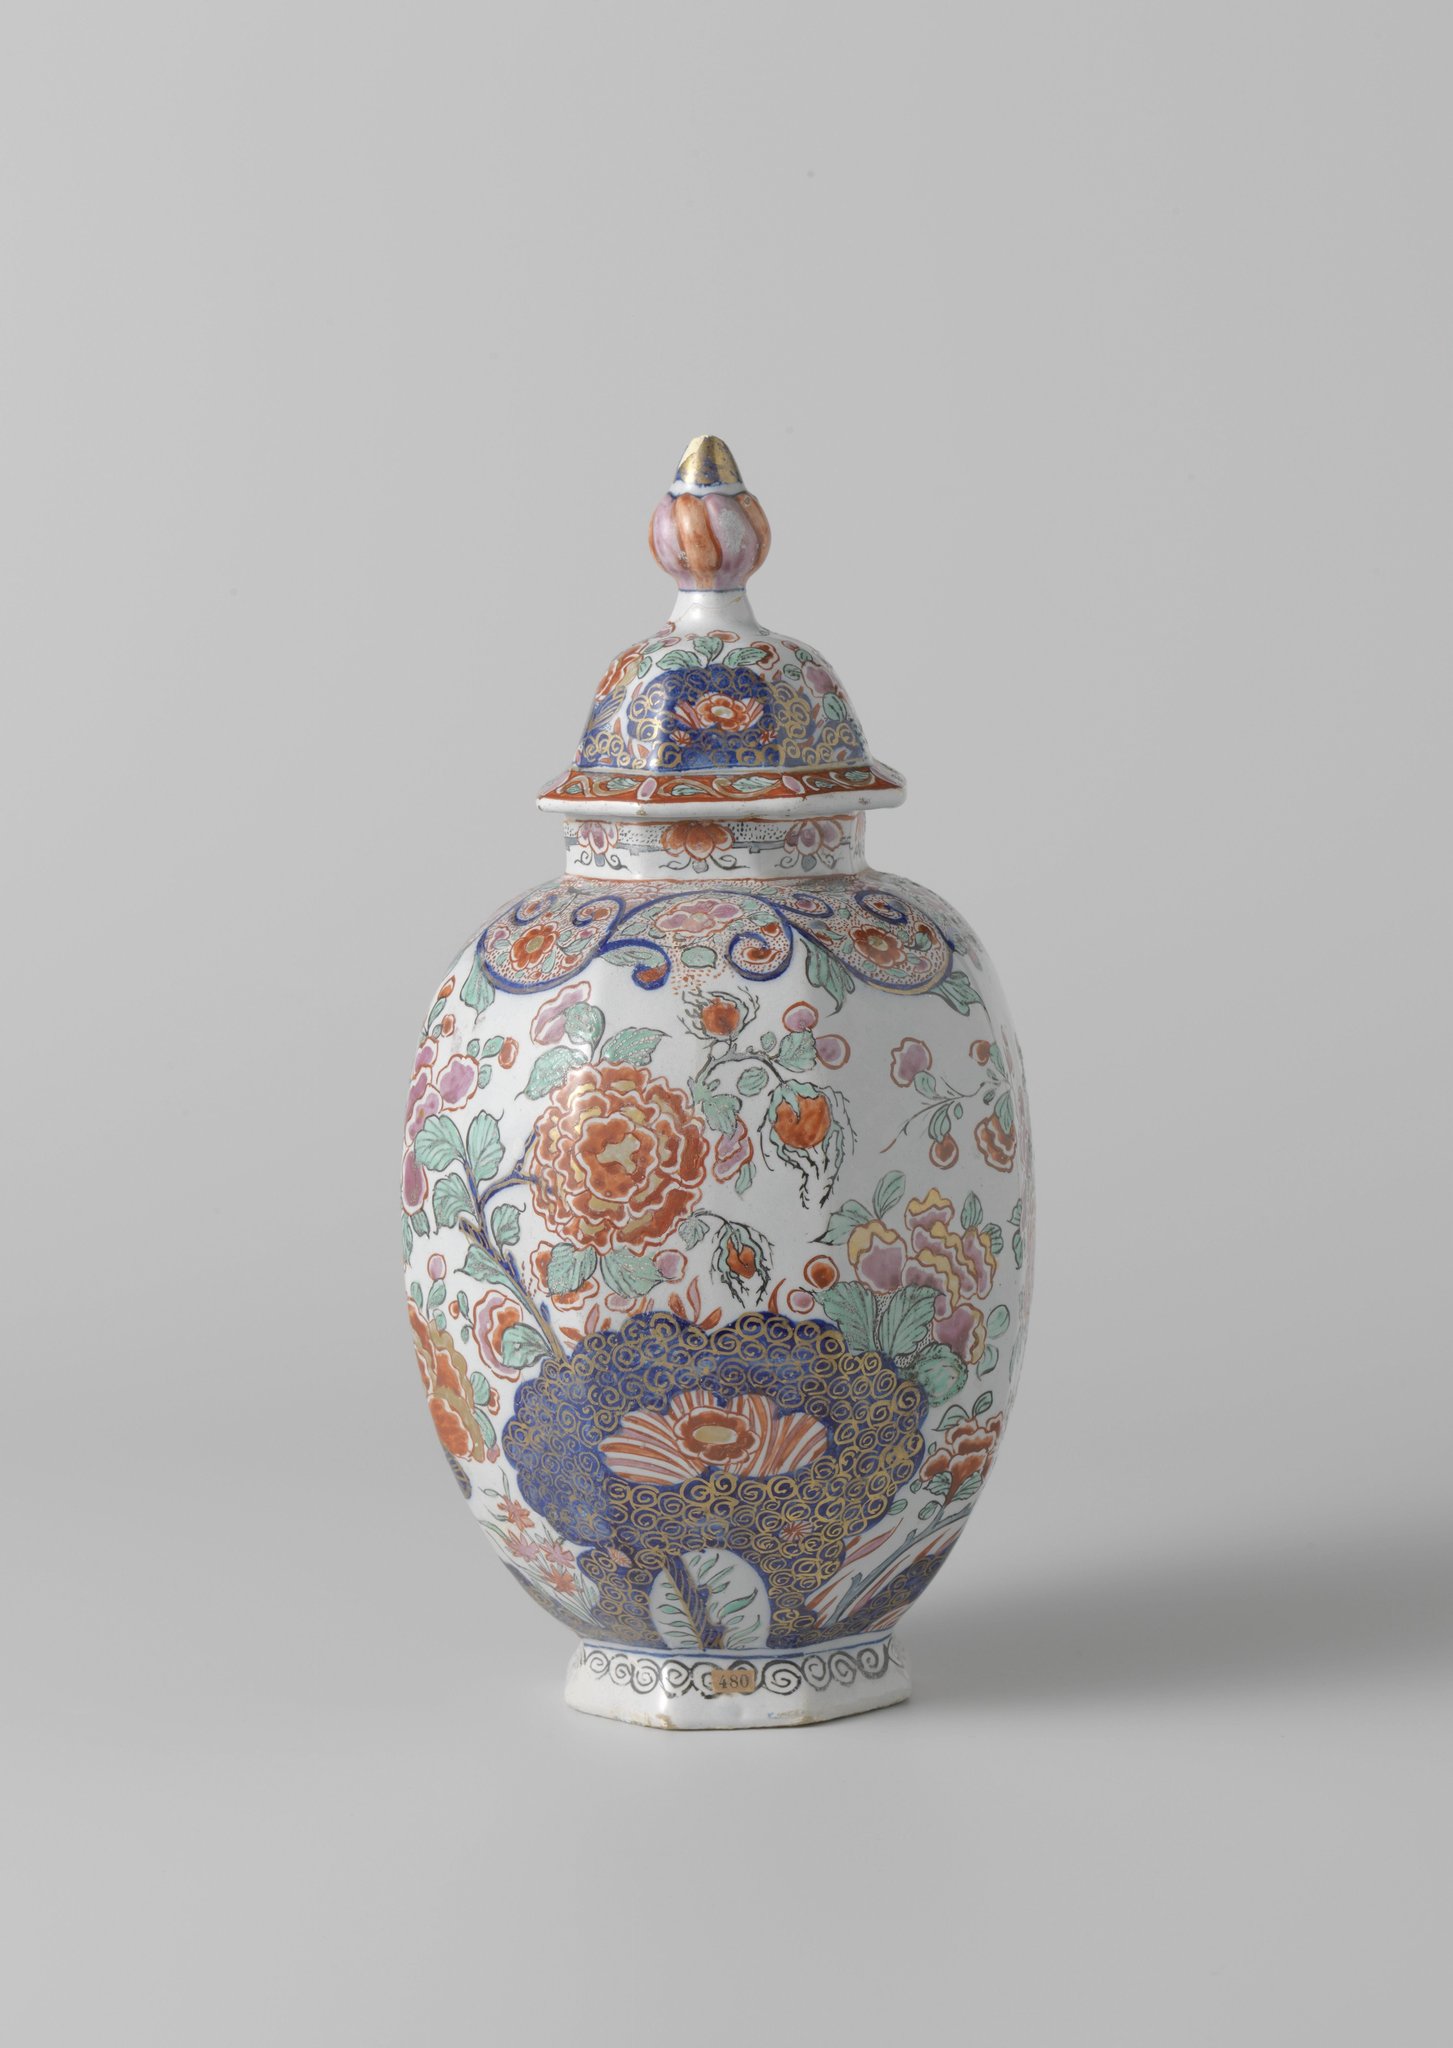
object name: lid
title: Deksel van pot veelkleurig beschilderde faïence van veelkleurig beschilderde faïence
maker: Anonymous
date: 1730-1760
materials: faience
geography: delft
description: Deksel van pot van veelkleurig beschilderde faïence. Veelkleurig beschilderd met bloemdecoraties. De pot is een onderdeel van een kaststel.